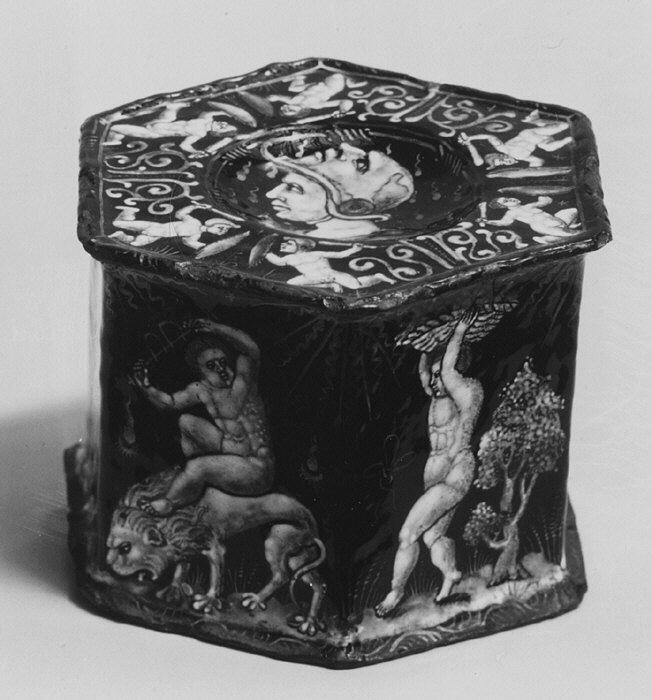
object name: saltcellar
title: Saltcellar (one of a pair)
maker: pierre reymond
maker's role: enameler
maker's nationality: french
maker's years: 1513-1590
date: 1540-1545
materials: copper, enamel, gilt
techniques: painting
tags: heads,male nudes,lions,trees